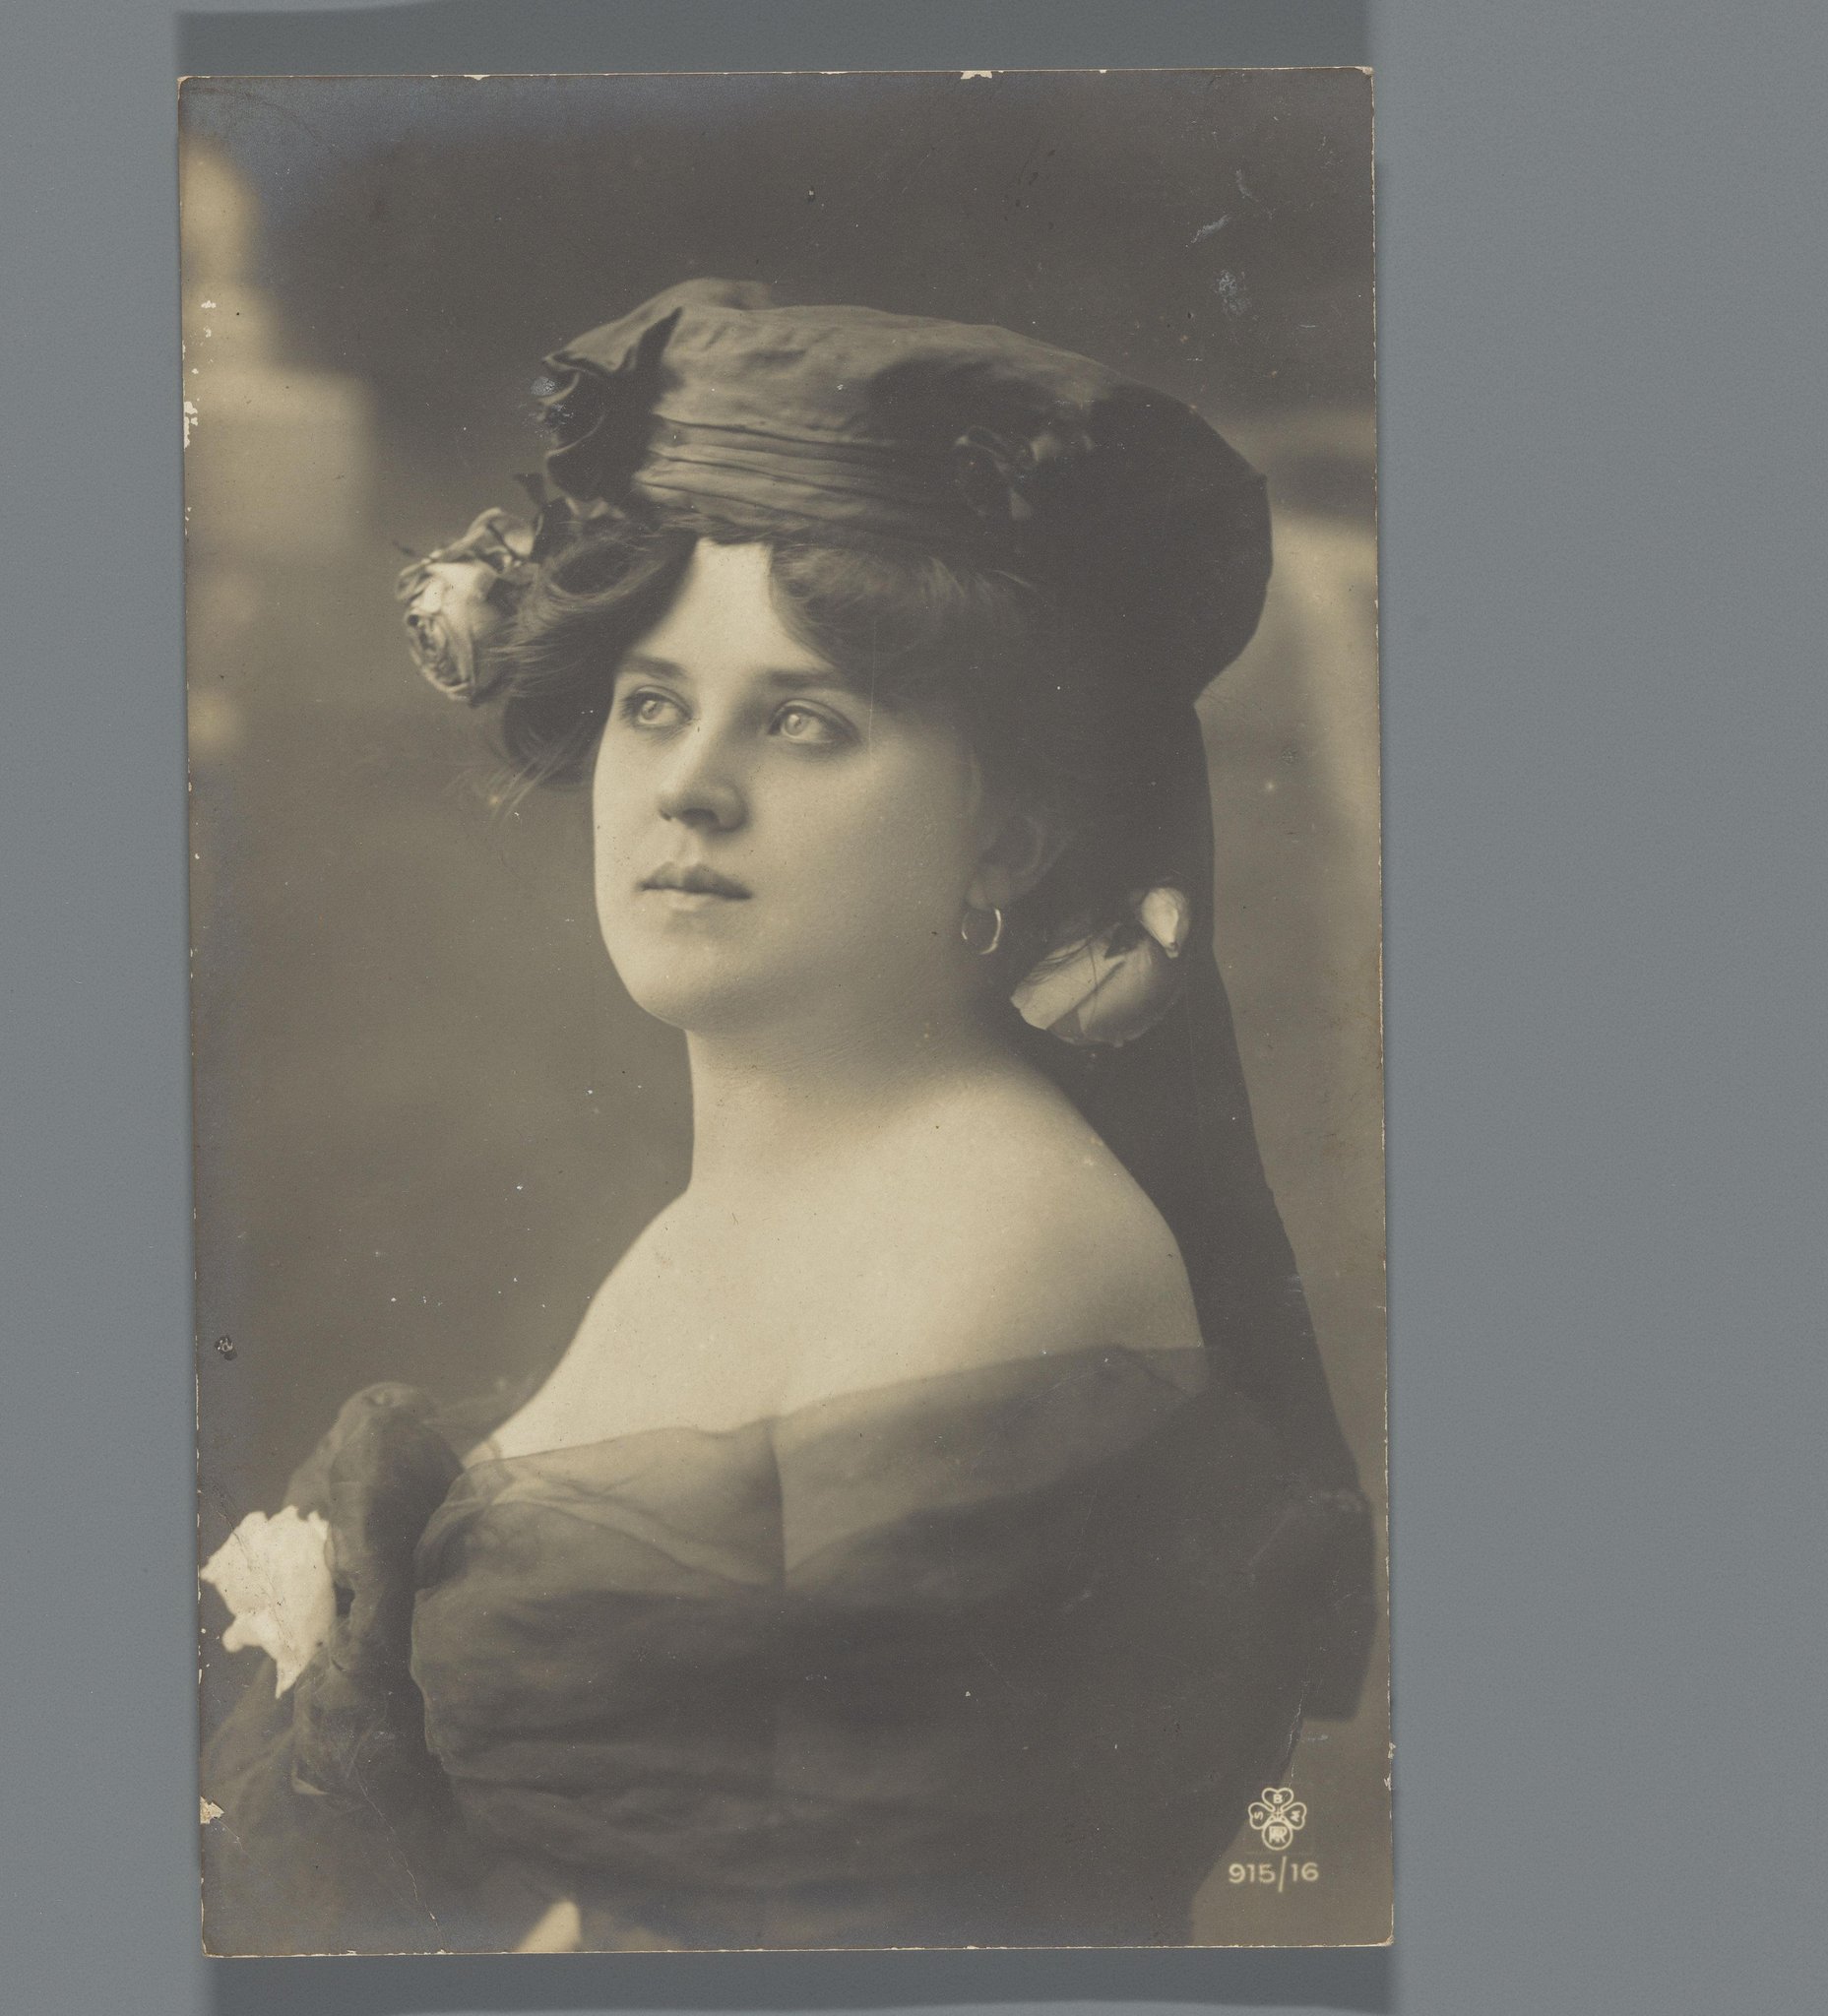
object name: photograph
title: Portret van een onbekende vrouw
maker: Anonymous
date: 1900-1920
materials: paper, ink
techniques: gelatin silver print, pen, writing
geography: berlin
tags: anonymous historical person portrayed - bb - woman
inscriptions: inscription: ‘Anna van Aalst/ Kerk Avezaath/ G’, number: ‘915/16’